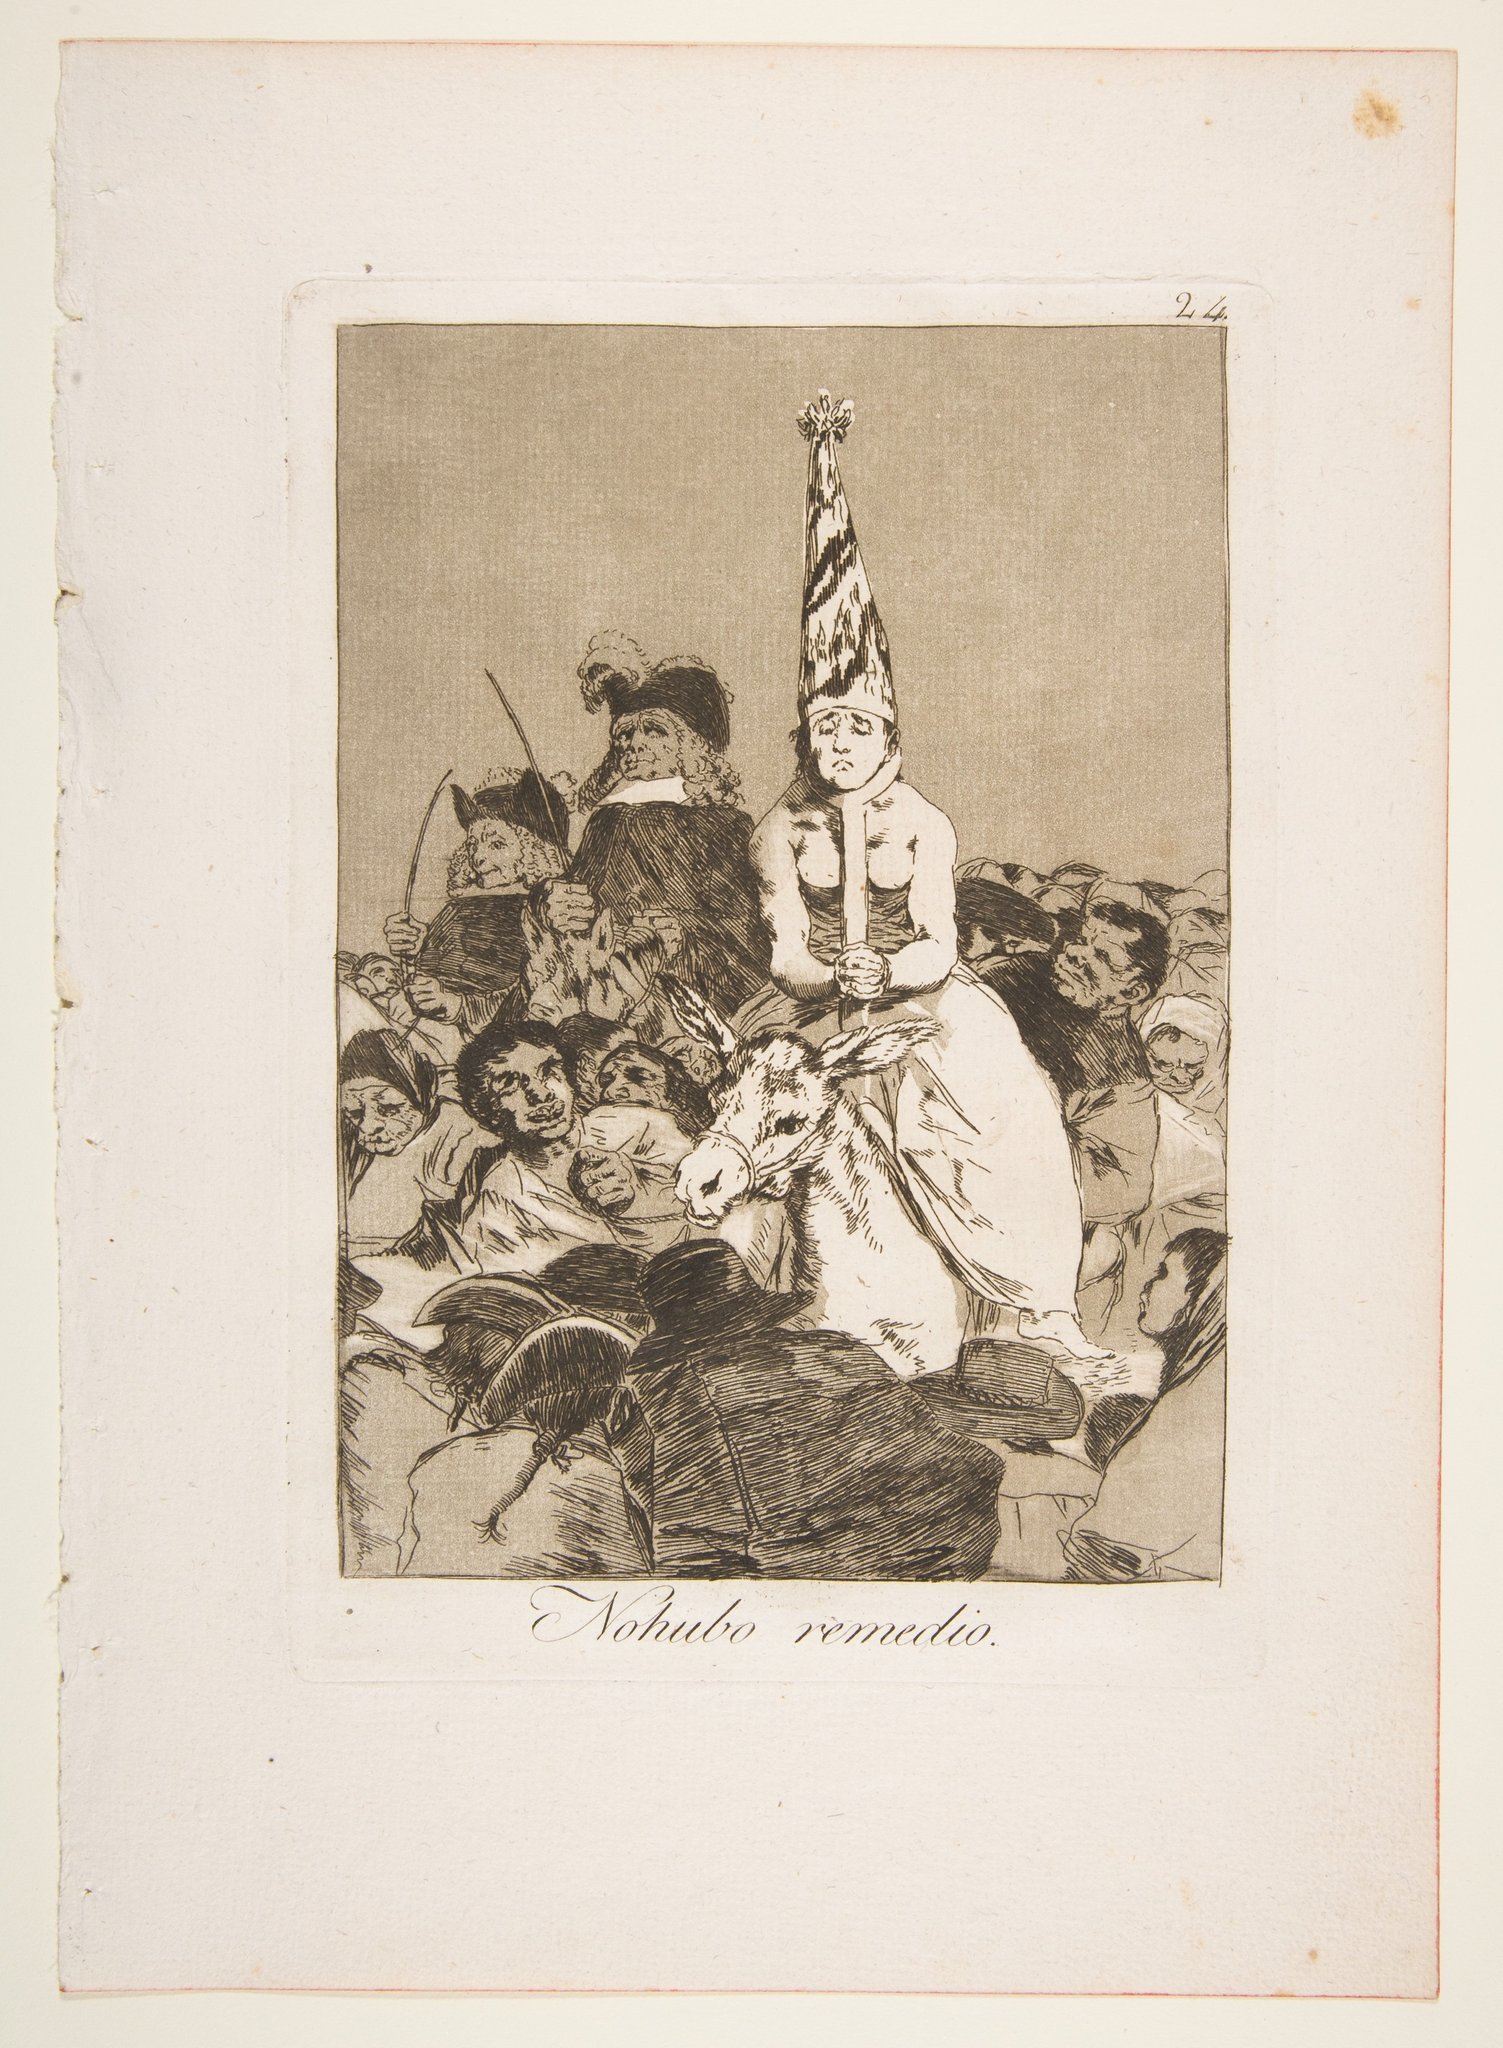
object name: print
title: Plate 24 from "Los Caprichos": Nothing could be done about It (Nohubo remedio)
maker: goya (francisco de goya y lucientes)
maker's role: artist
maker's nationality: spanish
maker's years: 1746-1828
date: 1799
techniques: aquatint, burnishing, etching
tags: men,donkeys